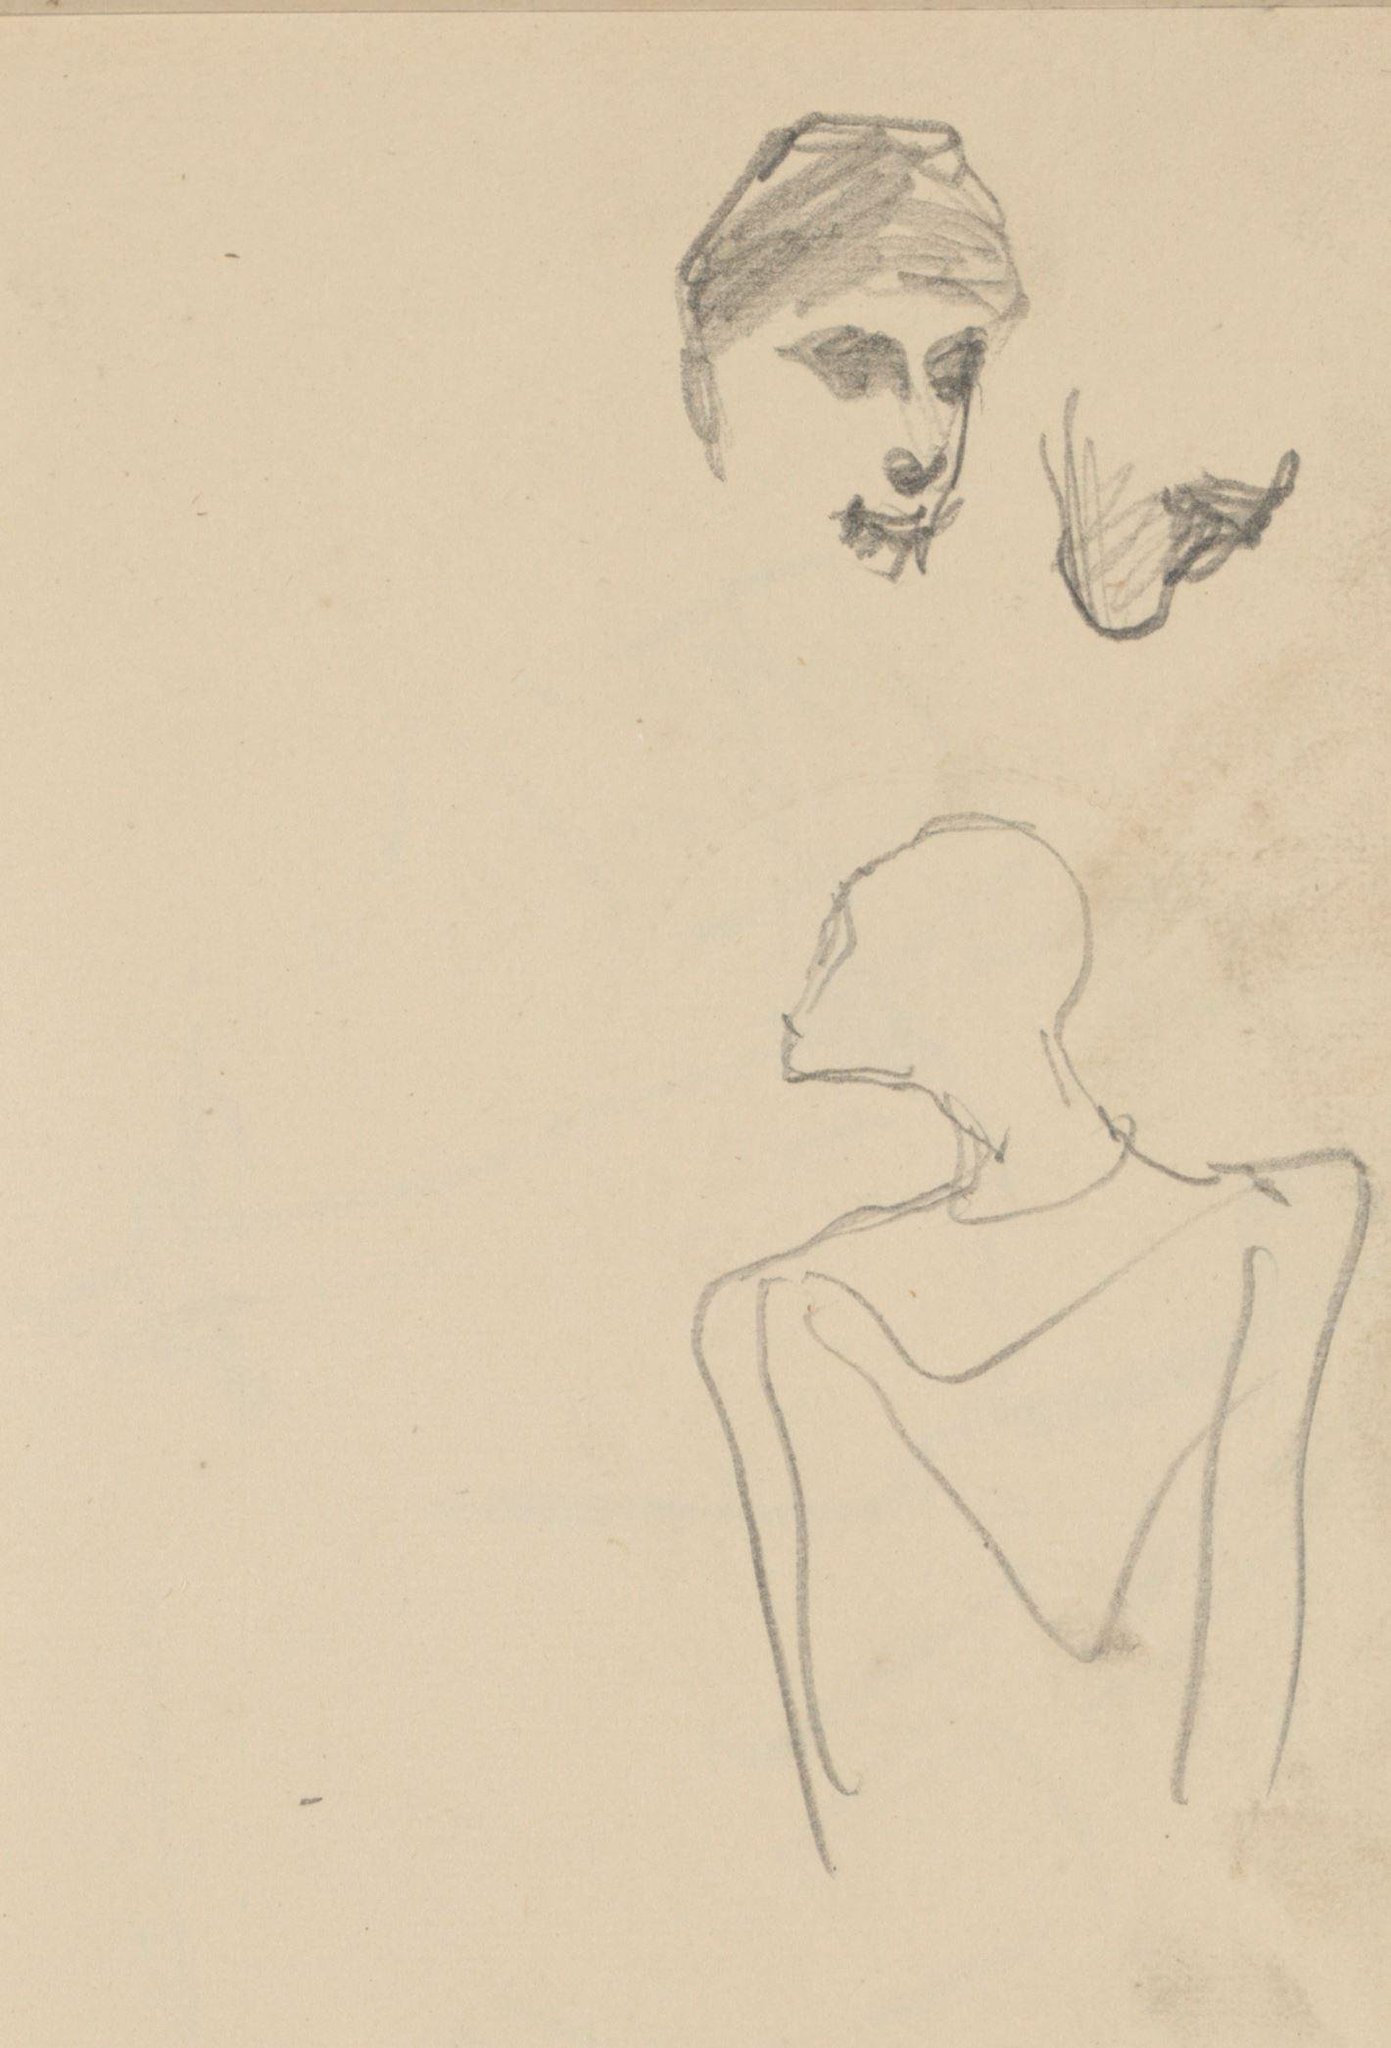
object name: sketchbook leaf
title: Figuurstudies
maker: george hendrik breitner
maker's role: draughtsman, painter, print maker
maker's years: 1857-1923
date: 1884-1886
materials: paper, pencil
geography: the hague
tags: adult woman, head (human) - aa - female human figure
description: Pagina 16 uit een schetsboek met 19 bladen.